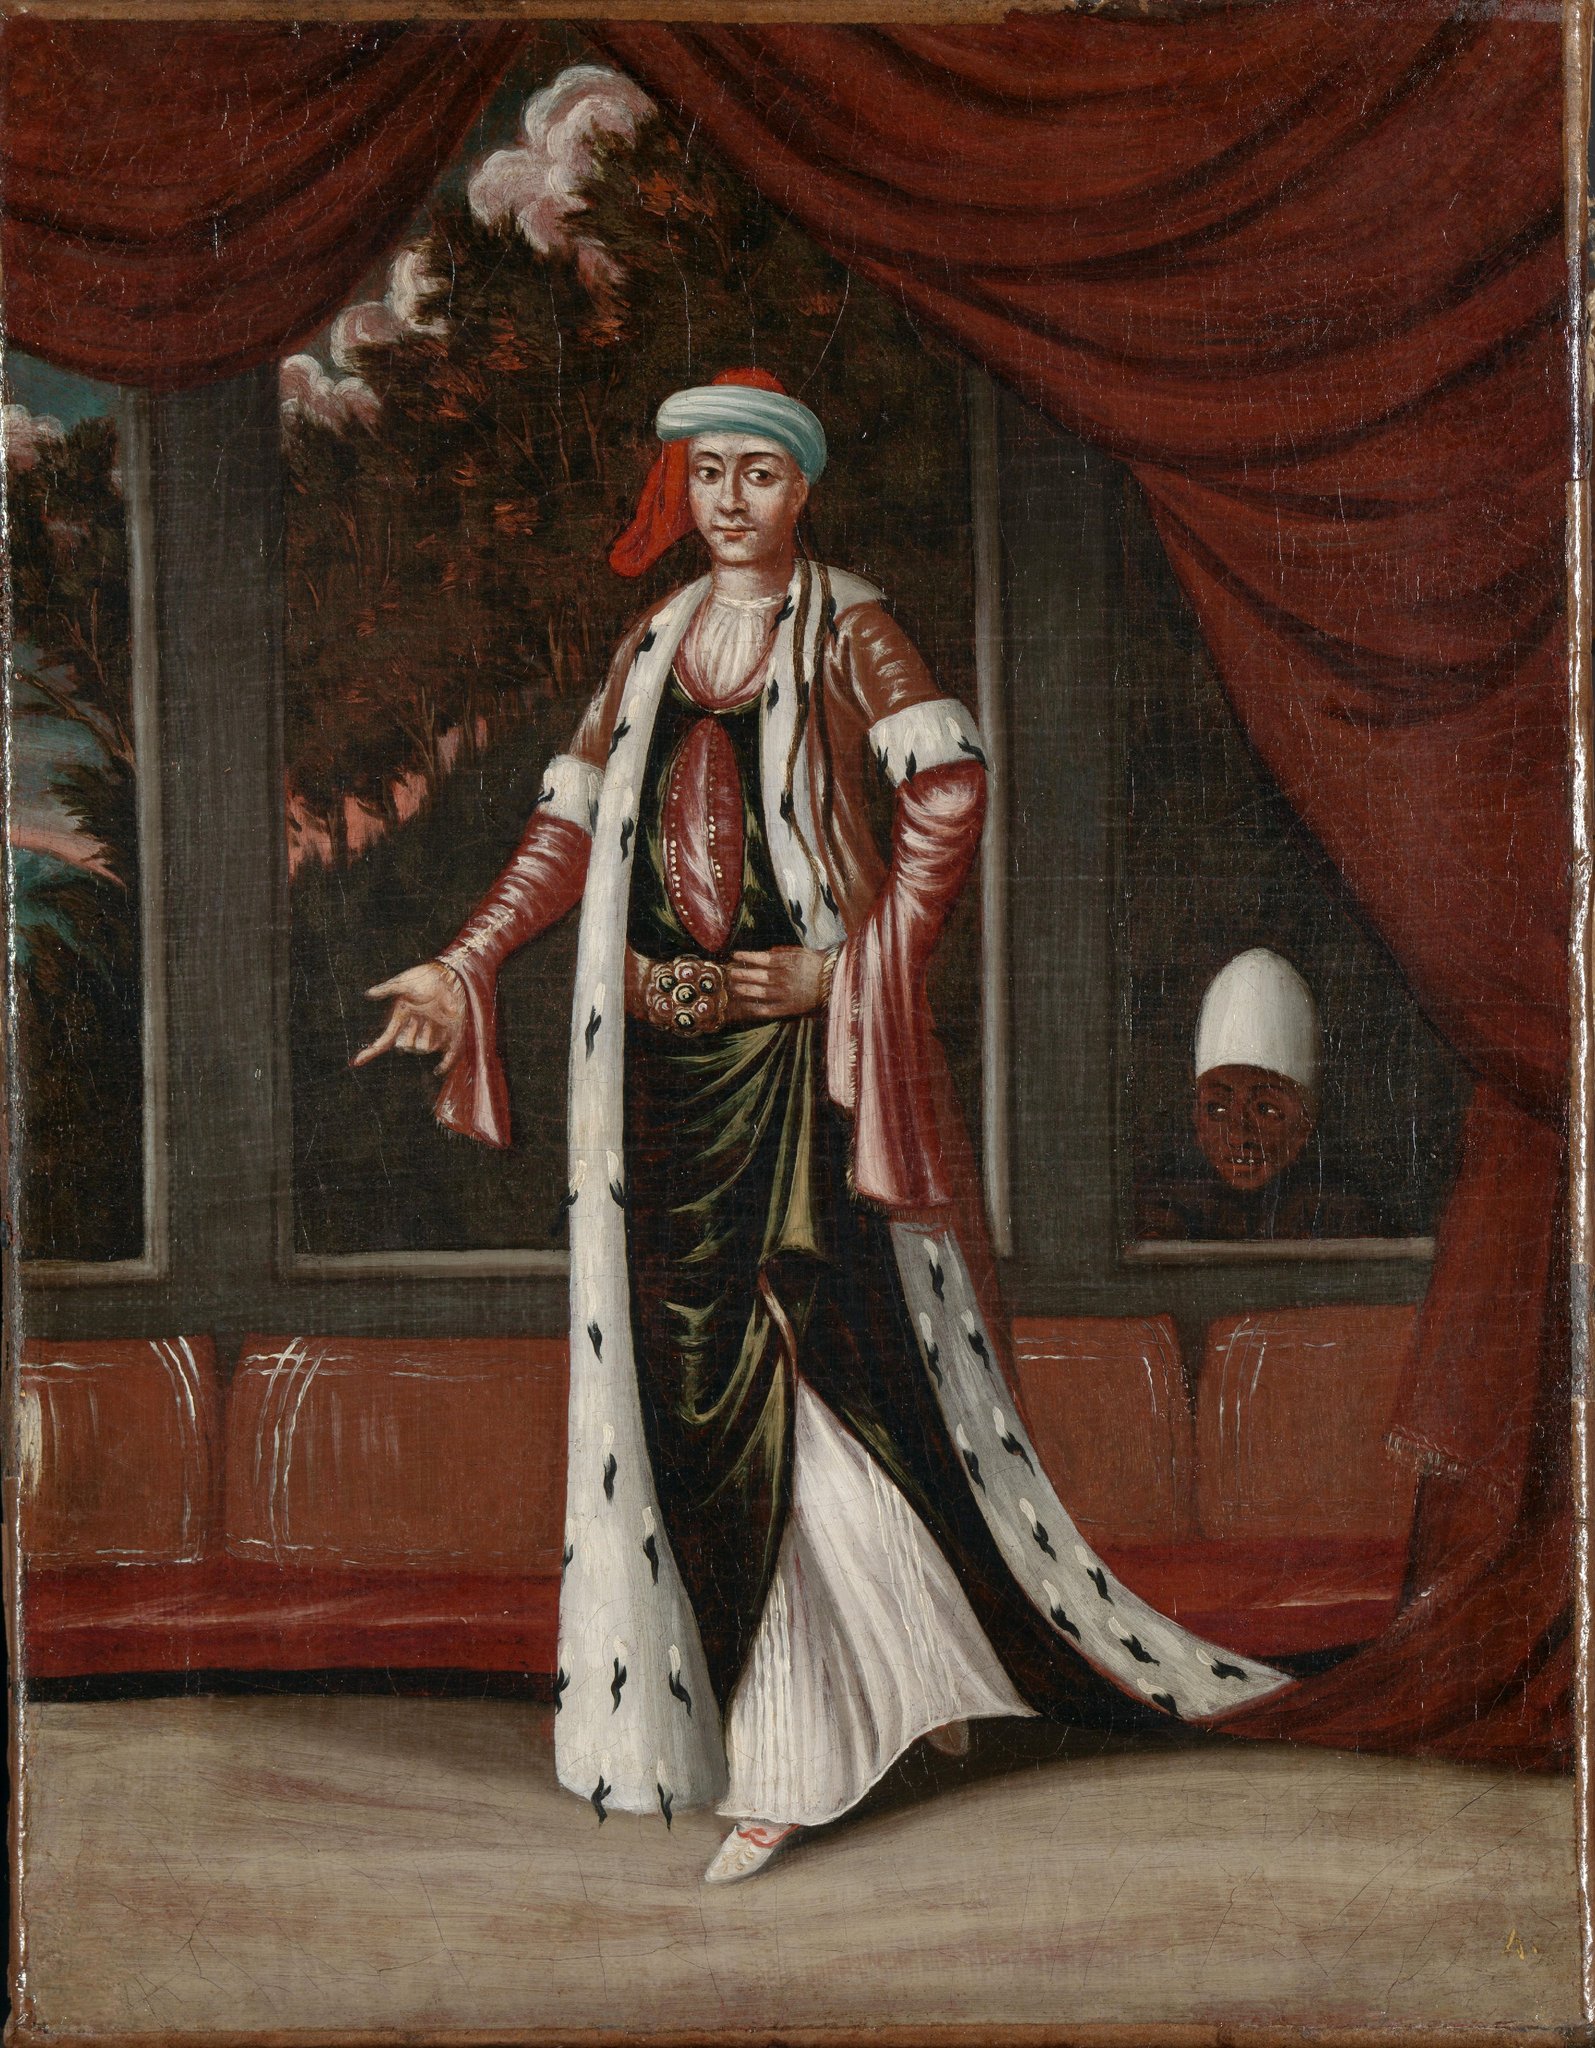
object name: painting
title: The Sultana-Mother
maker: jean baptiste vanmour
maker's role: painter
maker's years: 1671-1737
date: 1700-1737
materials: canvas, oil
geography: istanbul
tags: historical persons not known by name - bb - woman, mother of the ruler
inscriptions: number: ‘4’, inscription: ‘Sultane’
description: Portret van de sultane-moeder, staande ten voeten uit. Rechts het hoofd van een zwarte eunuch van de harem.